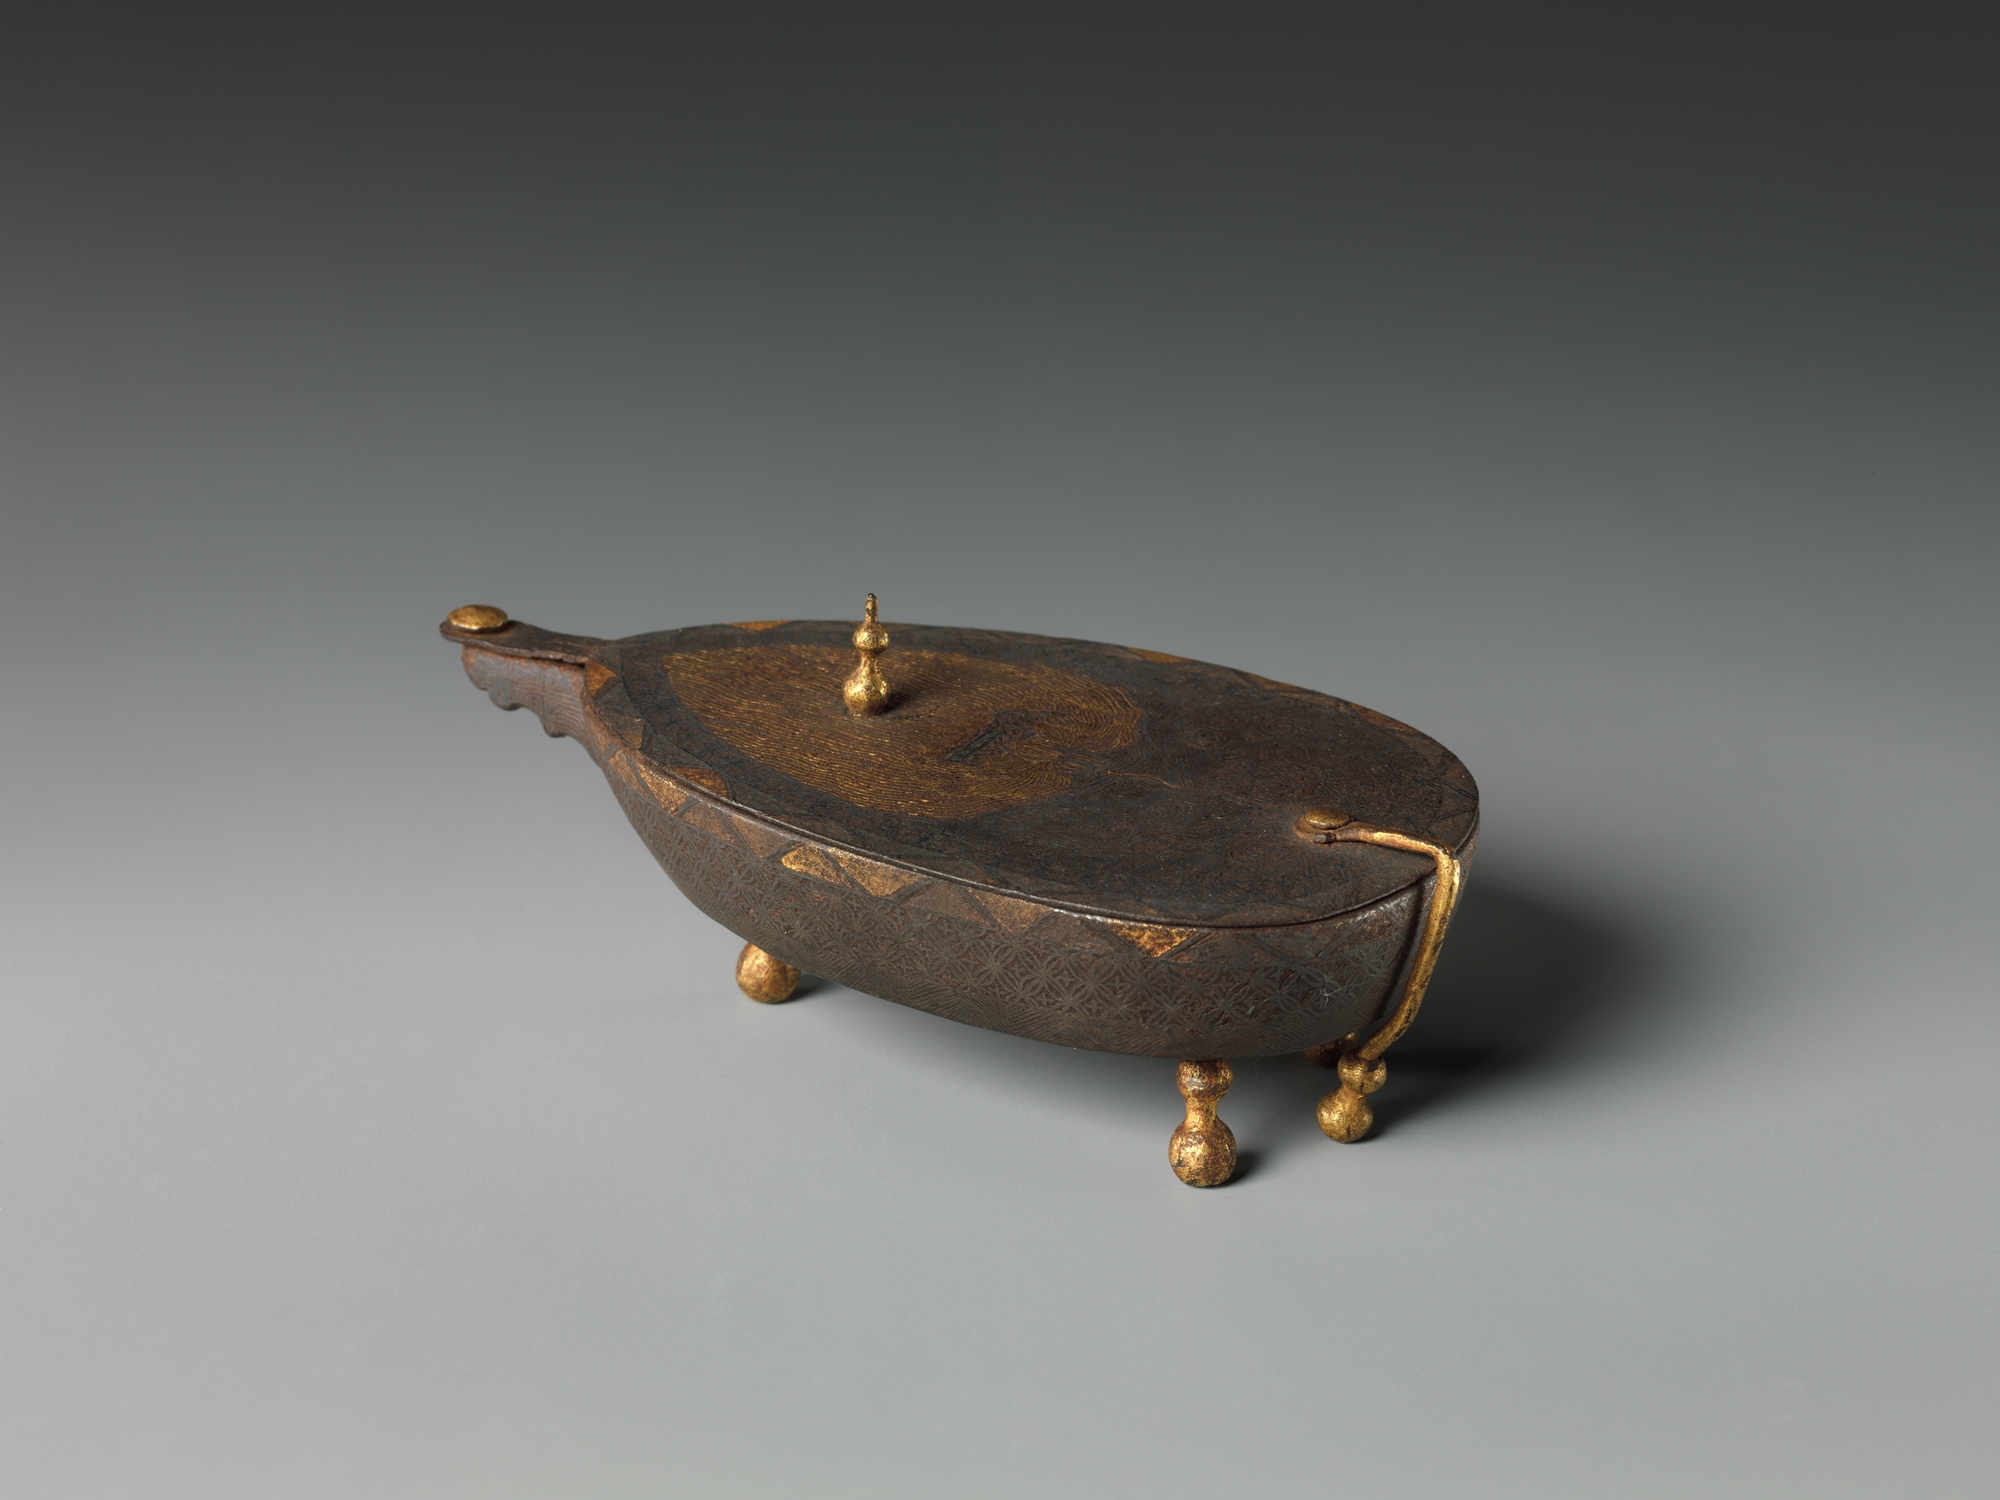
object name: incense box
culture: korean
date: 1301-1500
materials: gold, iron, silver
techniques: inlay